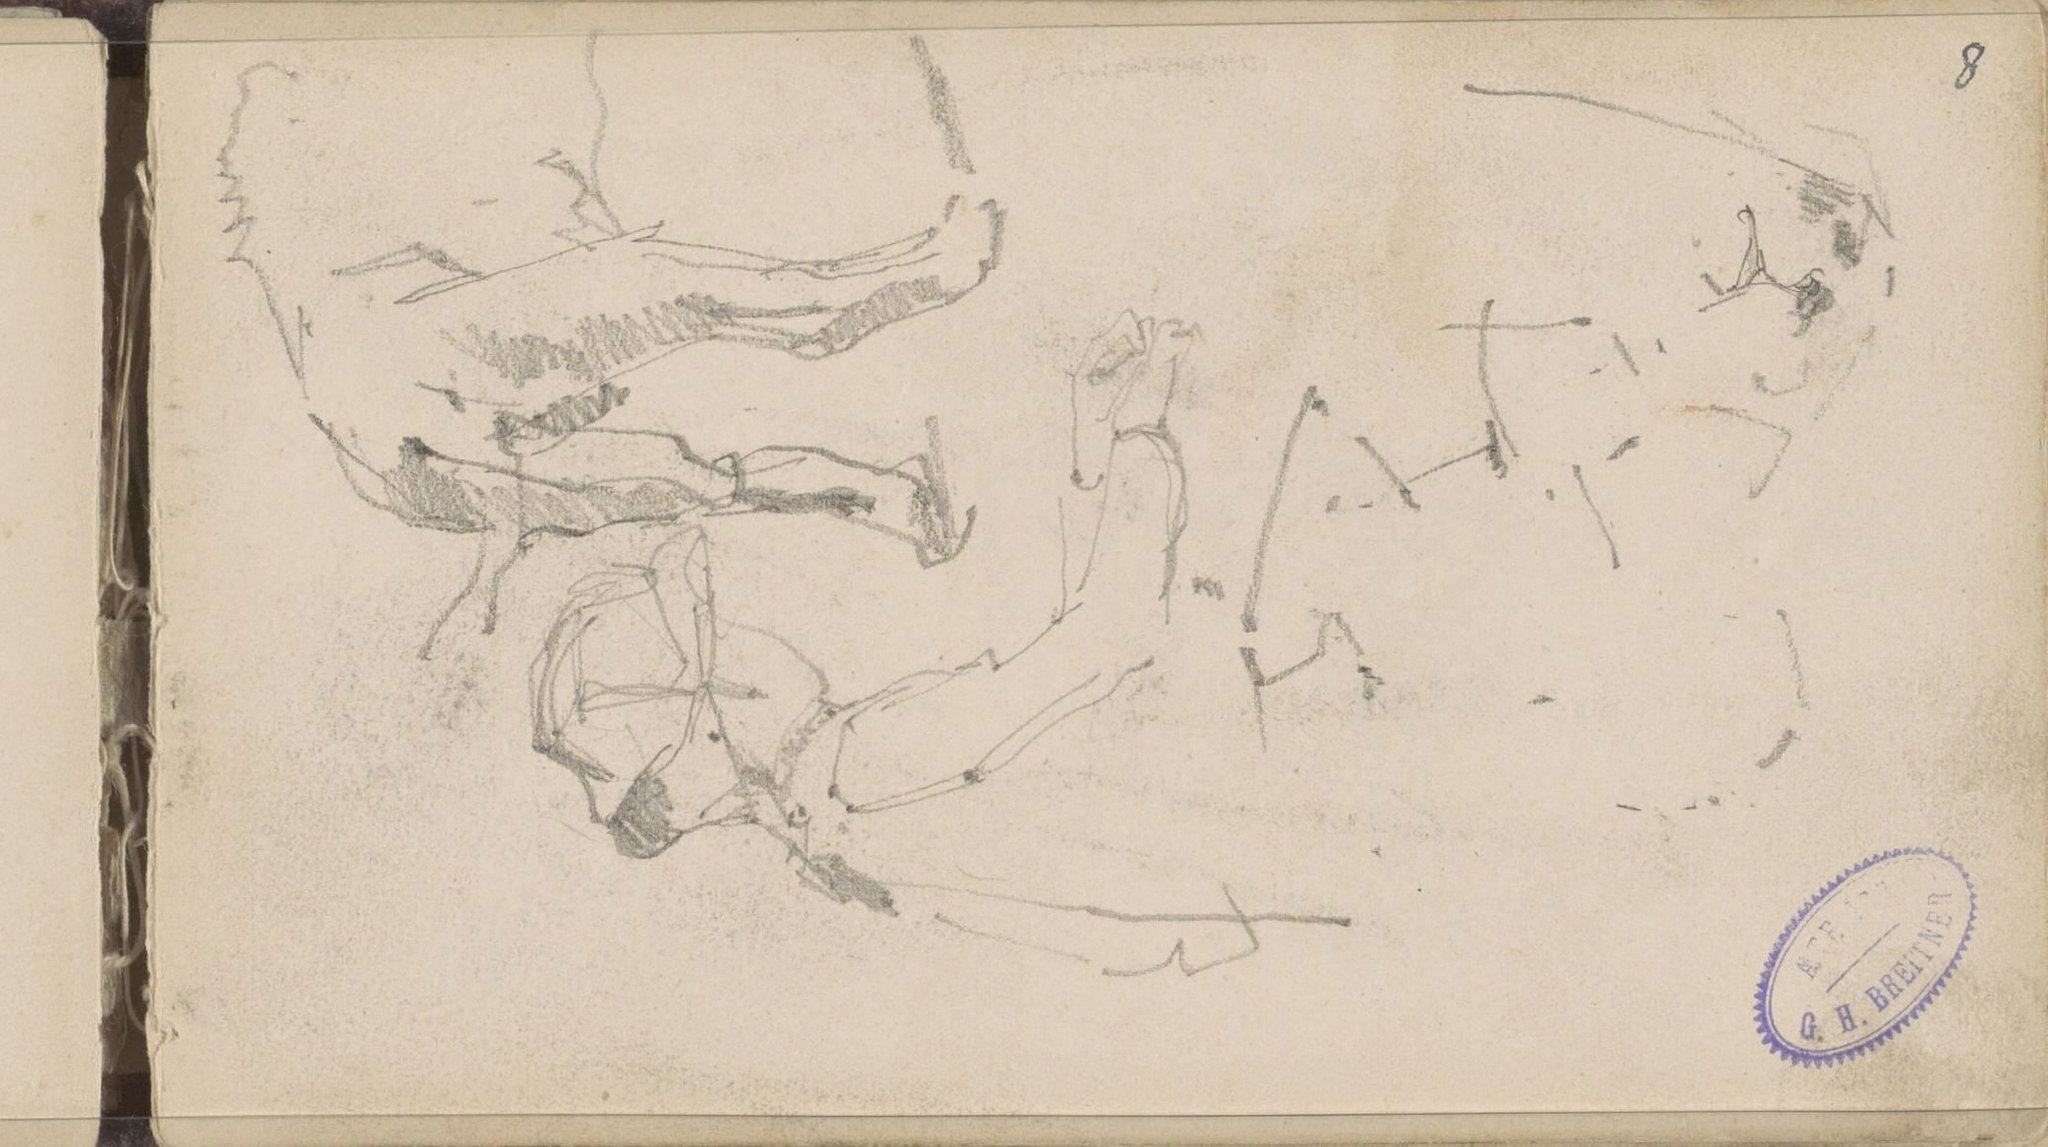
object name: sketchbook leaf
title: Achterlijf van een hond en een meisje met hoed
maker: george hendrik breitner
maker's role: draughtsman, painter, print maker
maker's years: 1857-1923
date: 1880-1882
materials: paper, pencil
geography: the hague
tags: girl (child between toddler and youth), dog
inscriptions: workshop stamp: Lugt 291d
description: Blad 8 recto uit een schetsboek met 16 bladen.